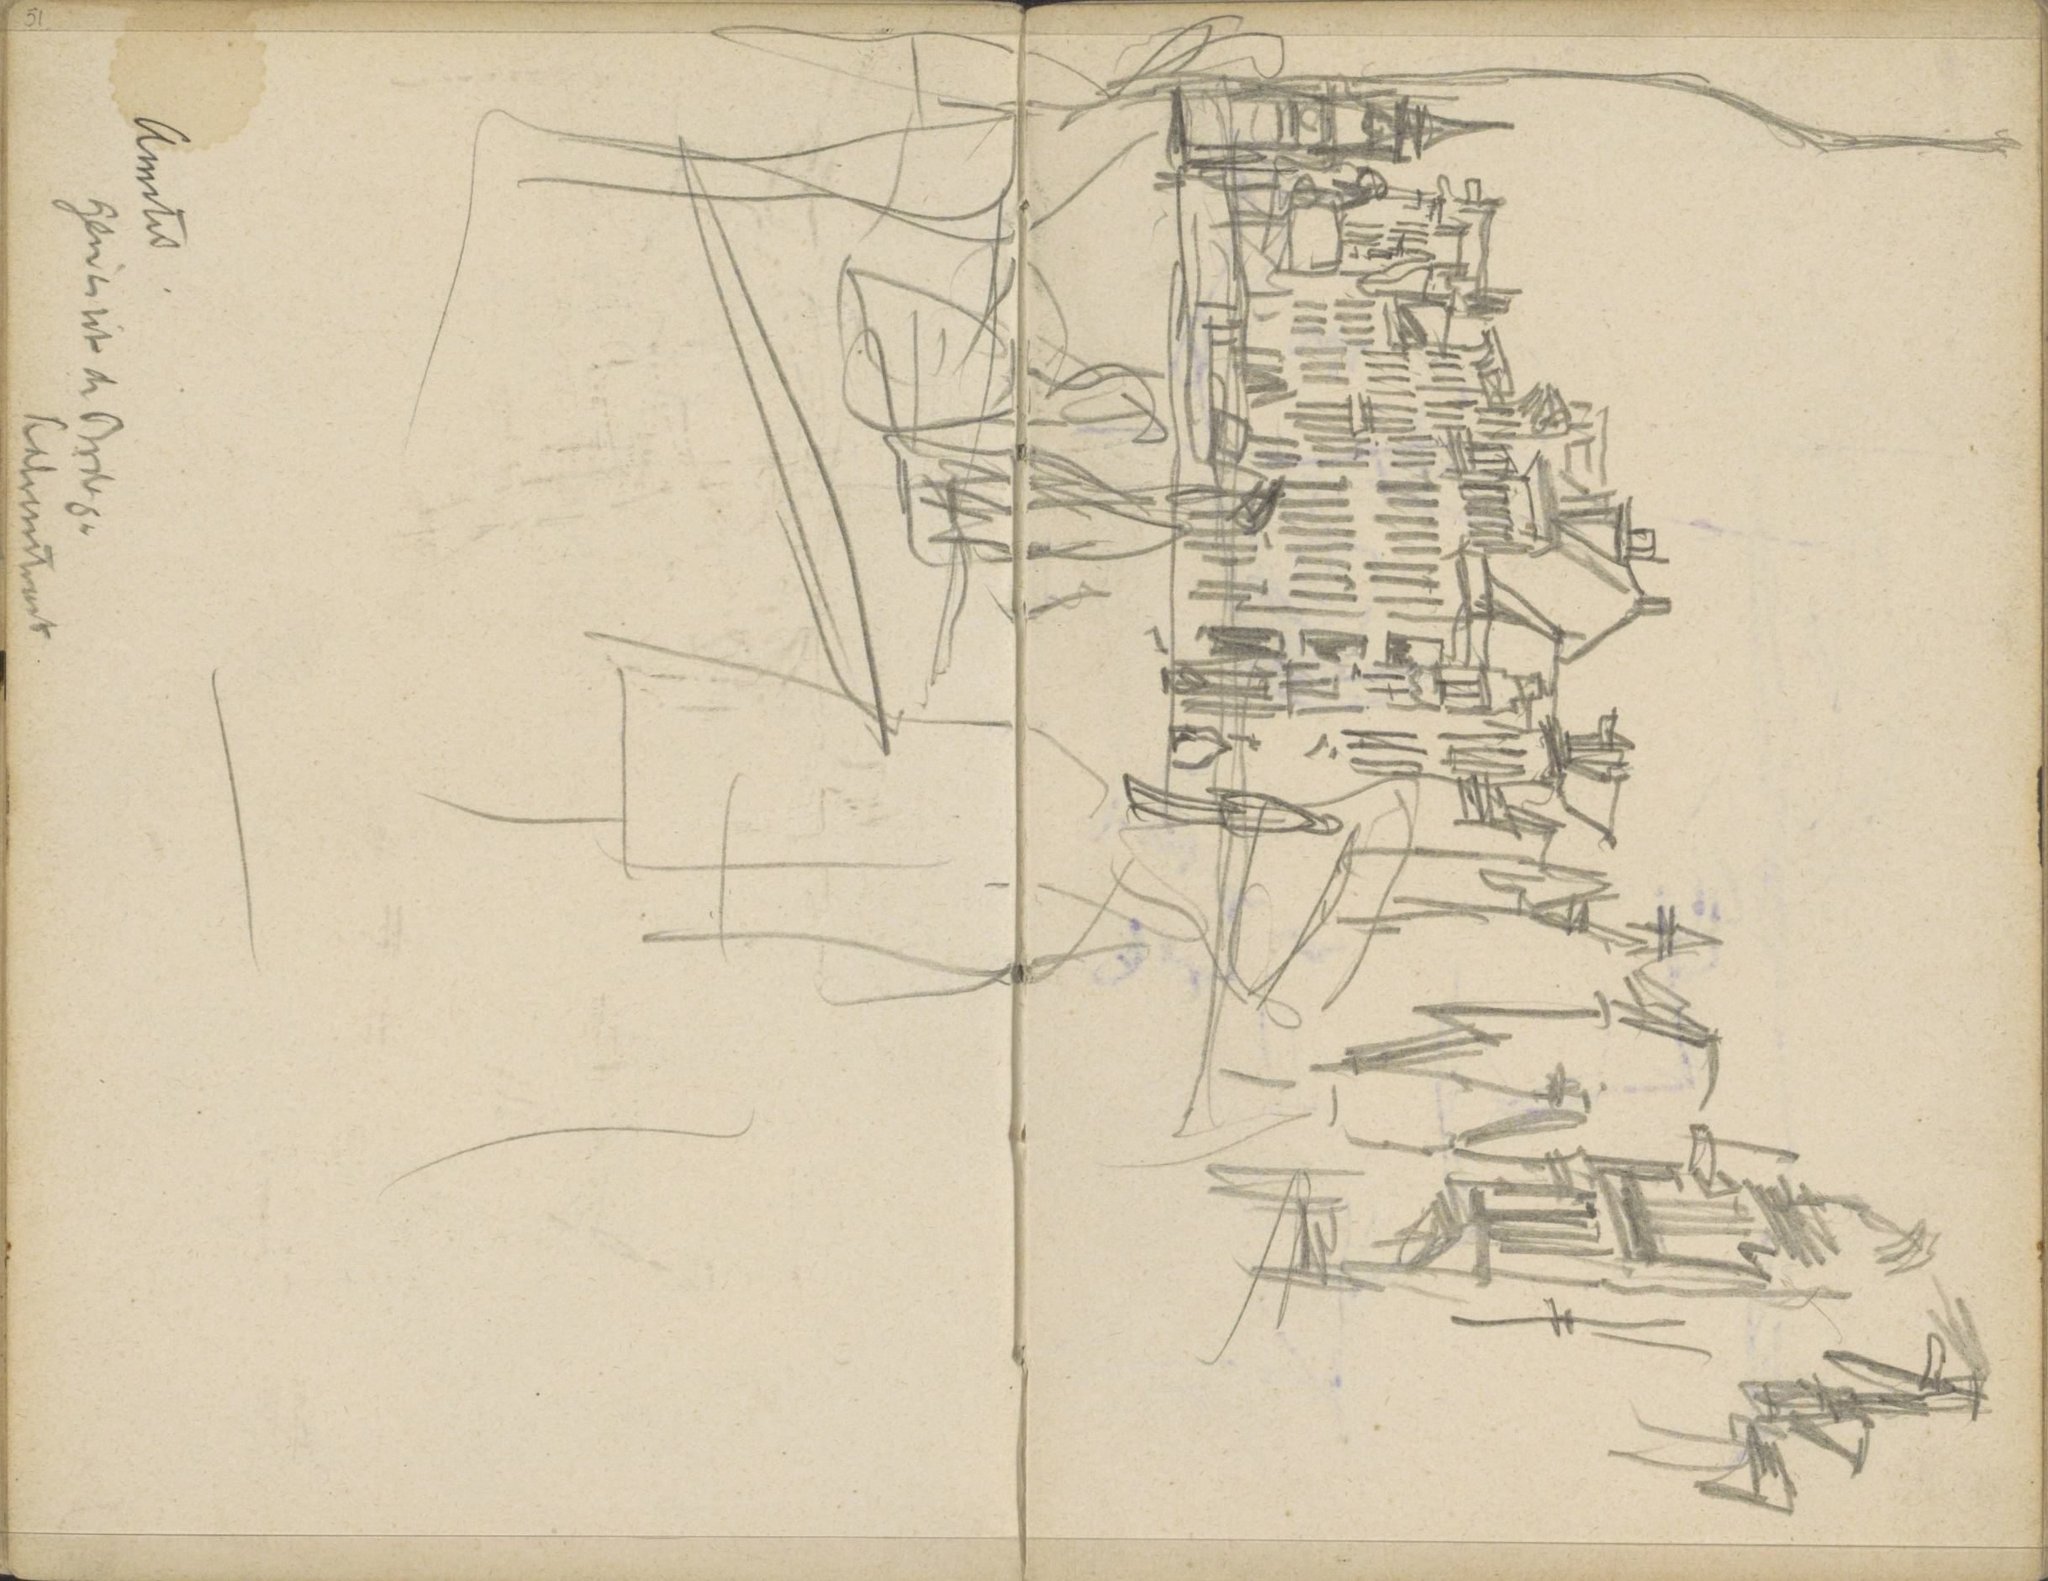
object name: sketchbook leaf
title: Muntplein en de Amstel te Amsterdam, gezien vanuit de Bodega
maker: george hendrik breitner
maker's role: draughtsman, painter, print maker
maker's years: 1857-1923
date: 1903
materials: pencil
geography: amsterdam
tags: urban housing, street (+ city(-scape) with figures, staffage)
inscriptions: annotation: ‘Amstel/ gezien uit de Bodega/ Kalverstraat’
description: Gezicht op het Muntplein en de Amstel te Amsterdam, gezien vanuit de Bodega. Pagina 51 en pagina 52 uit een schetsboek met 46 bladen vervaardigd te Amsterdam en Haarlem.